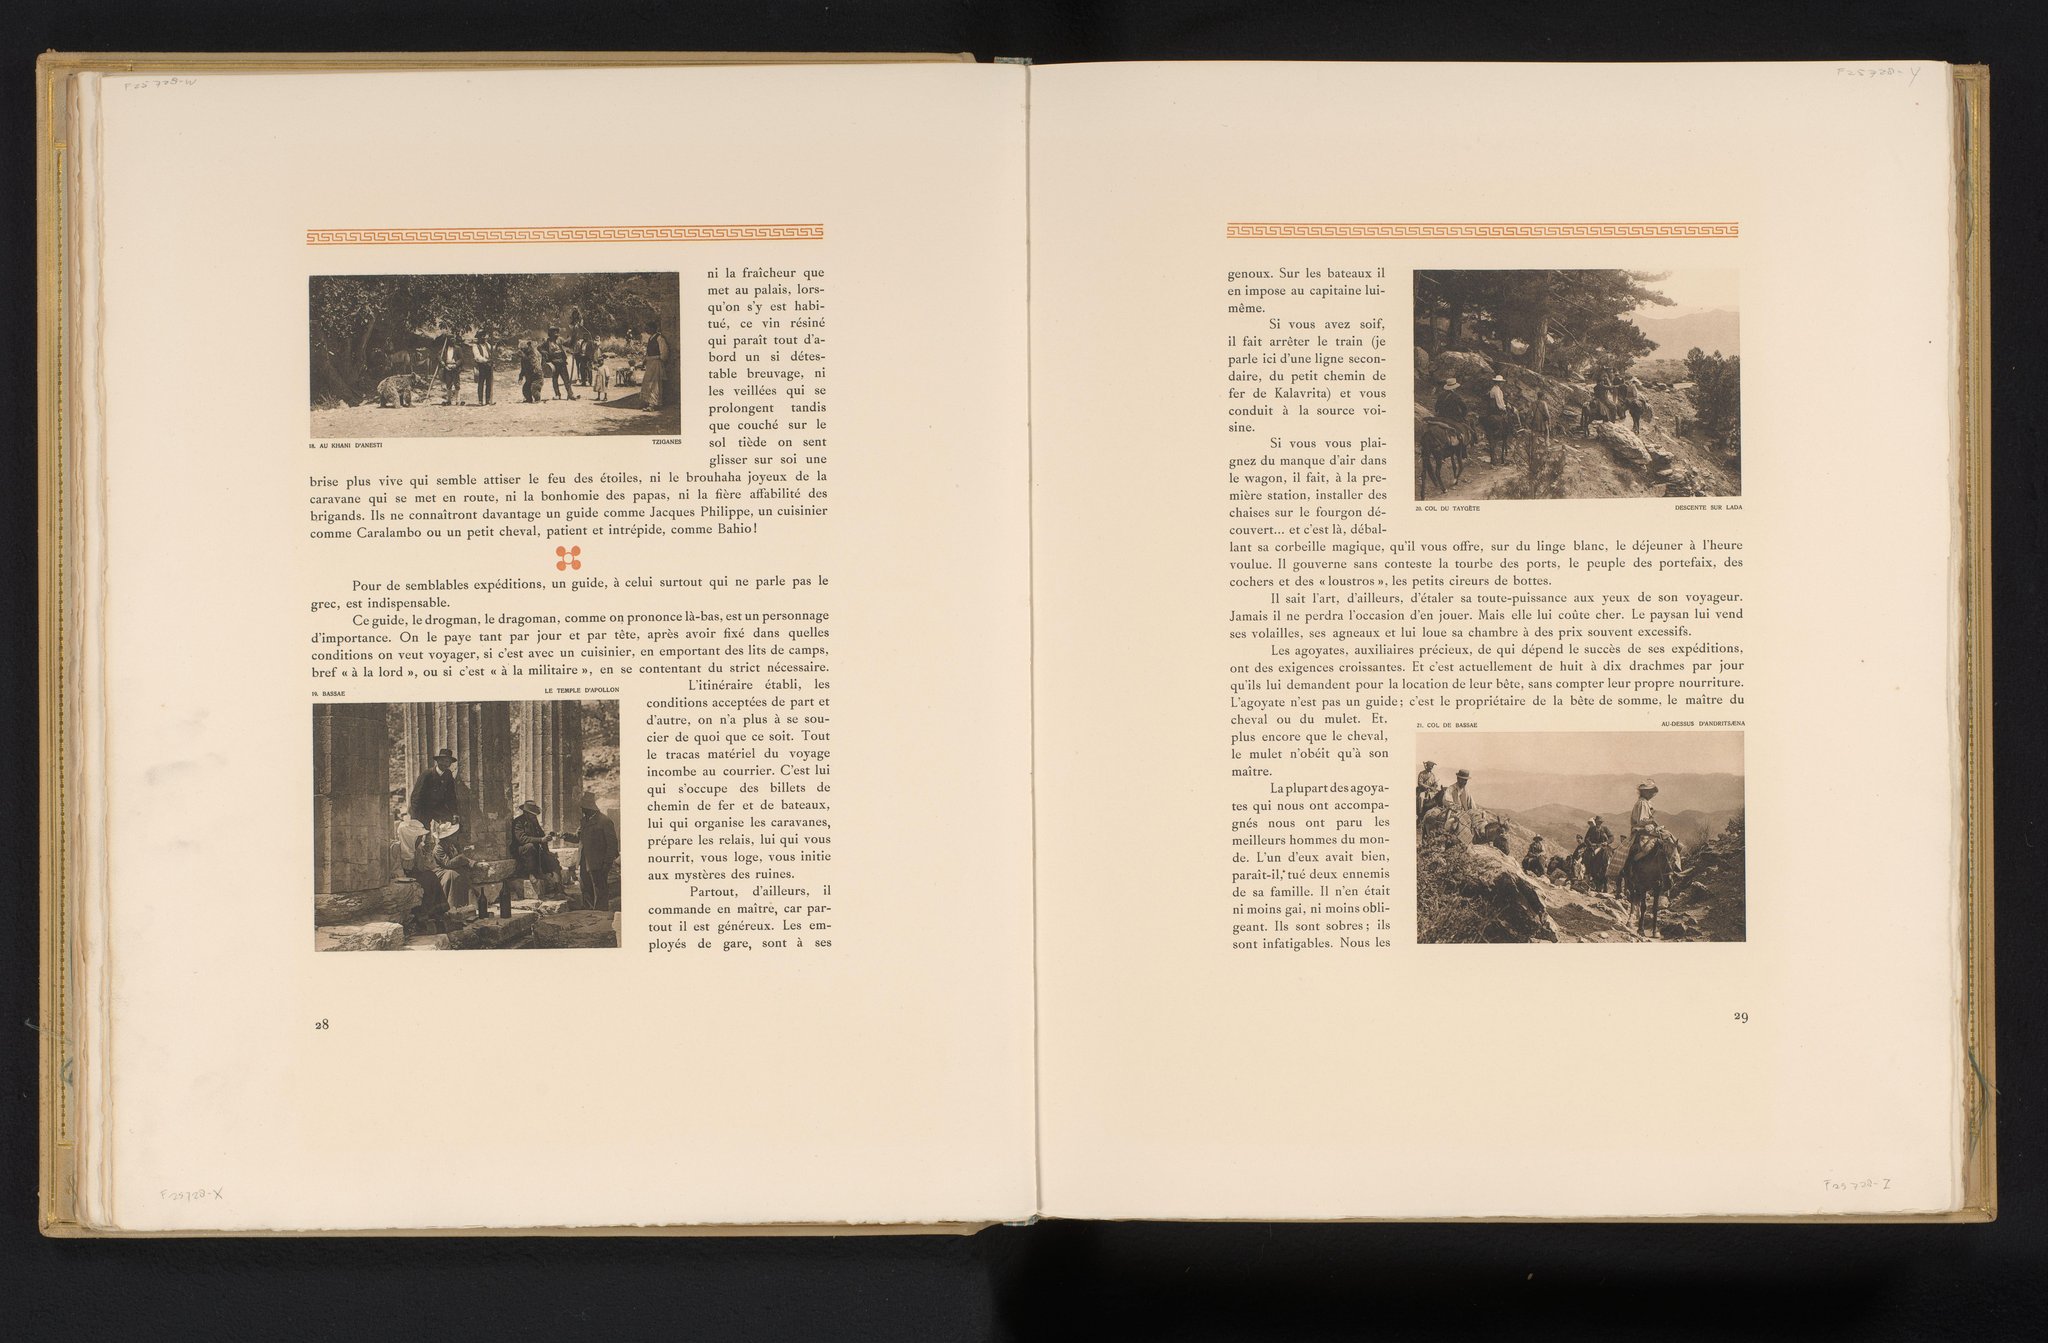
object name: page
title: Reizigers bij de tempel van Apollon Epikourios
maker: frédéric boissonnas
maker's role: fotograaf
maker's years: 1858-1946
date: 1905-1910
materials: paper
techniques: photograph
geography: berlin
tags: (traveller) resting in the open air, temple, shrine ~ greek religion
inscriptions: number: ‘19.’